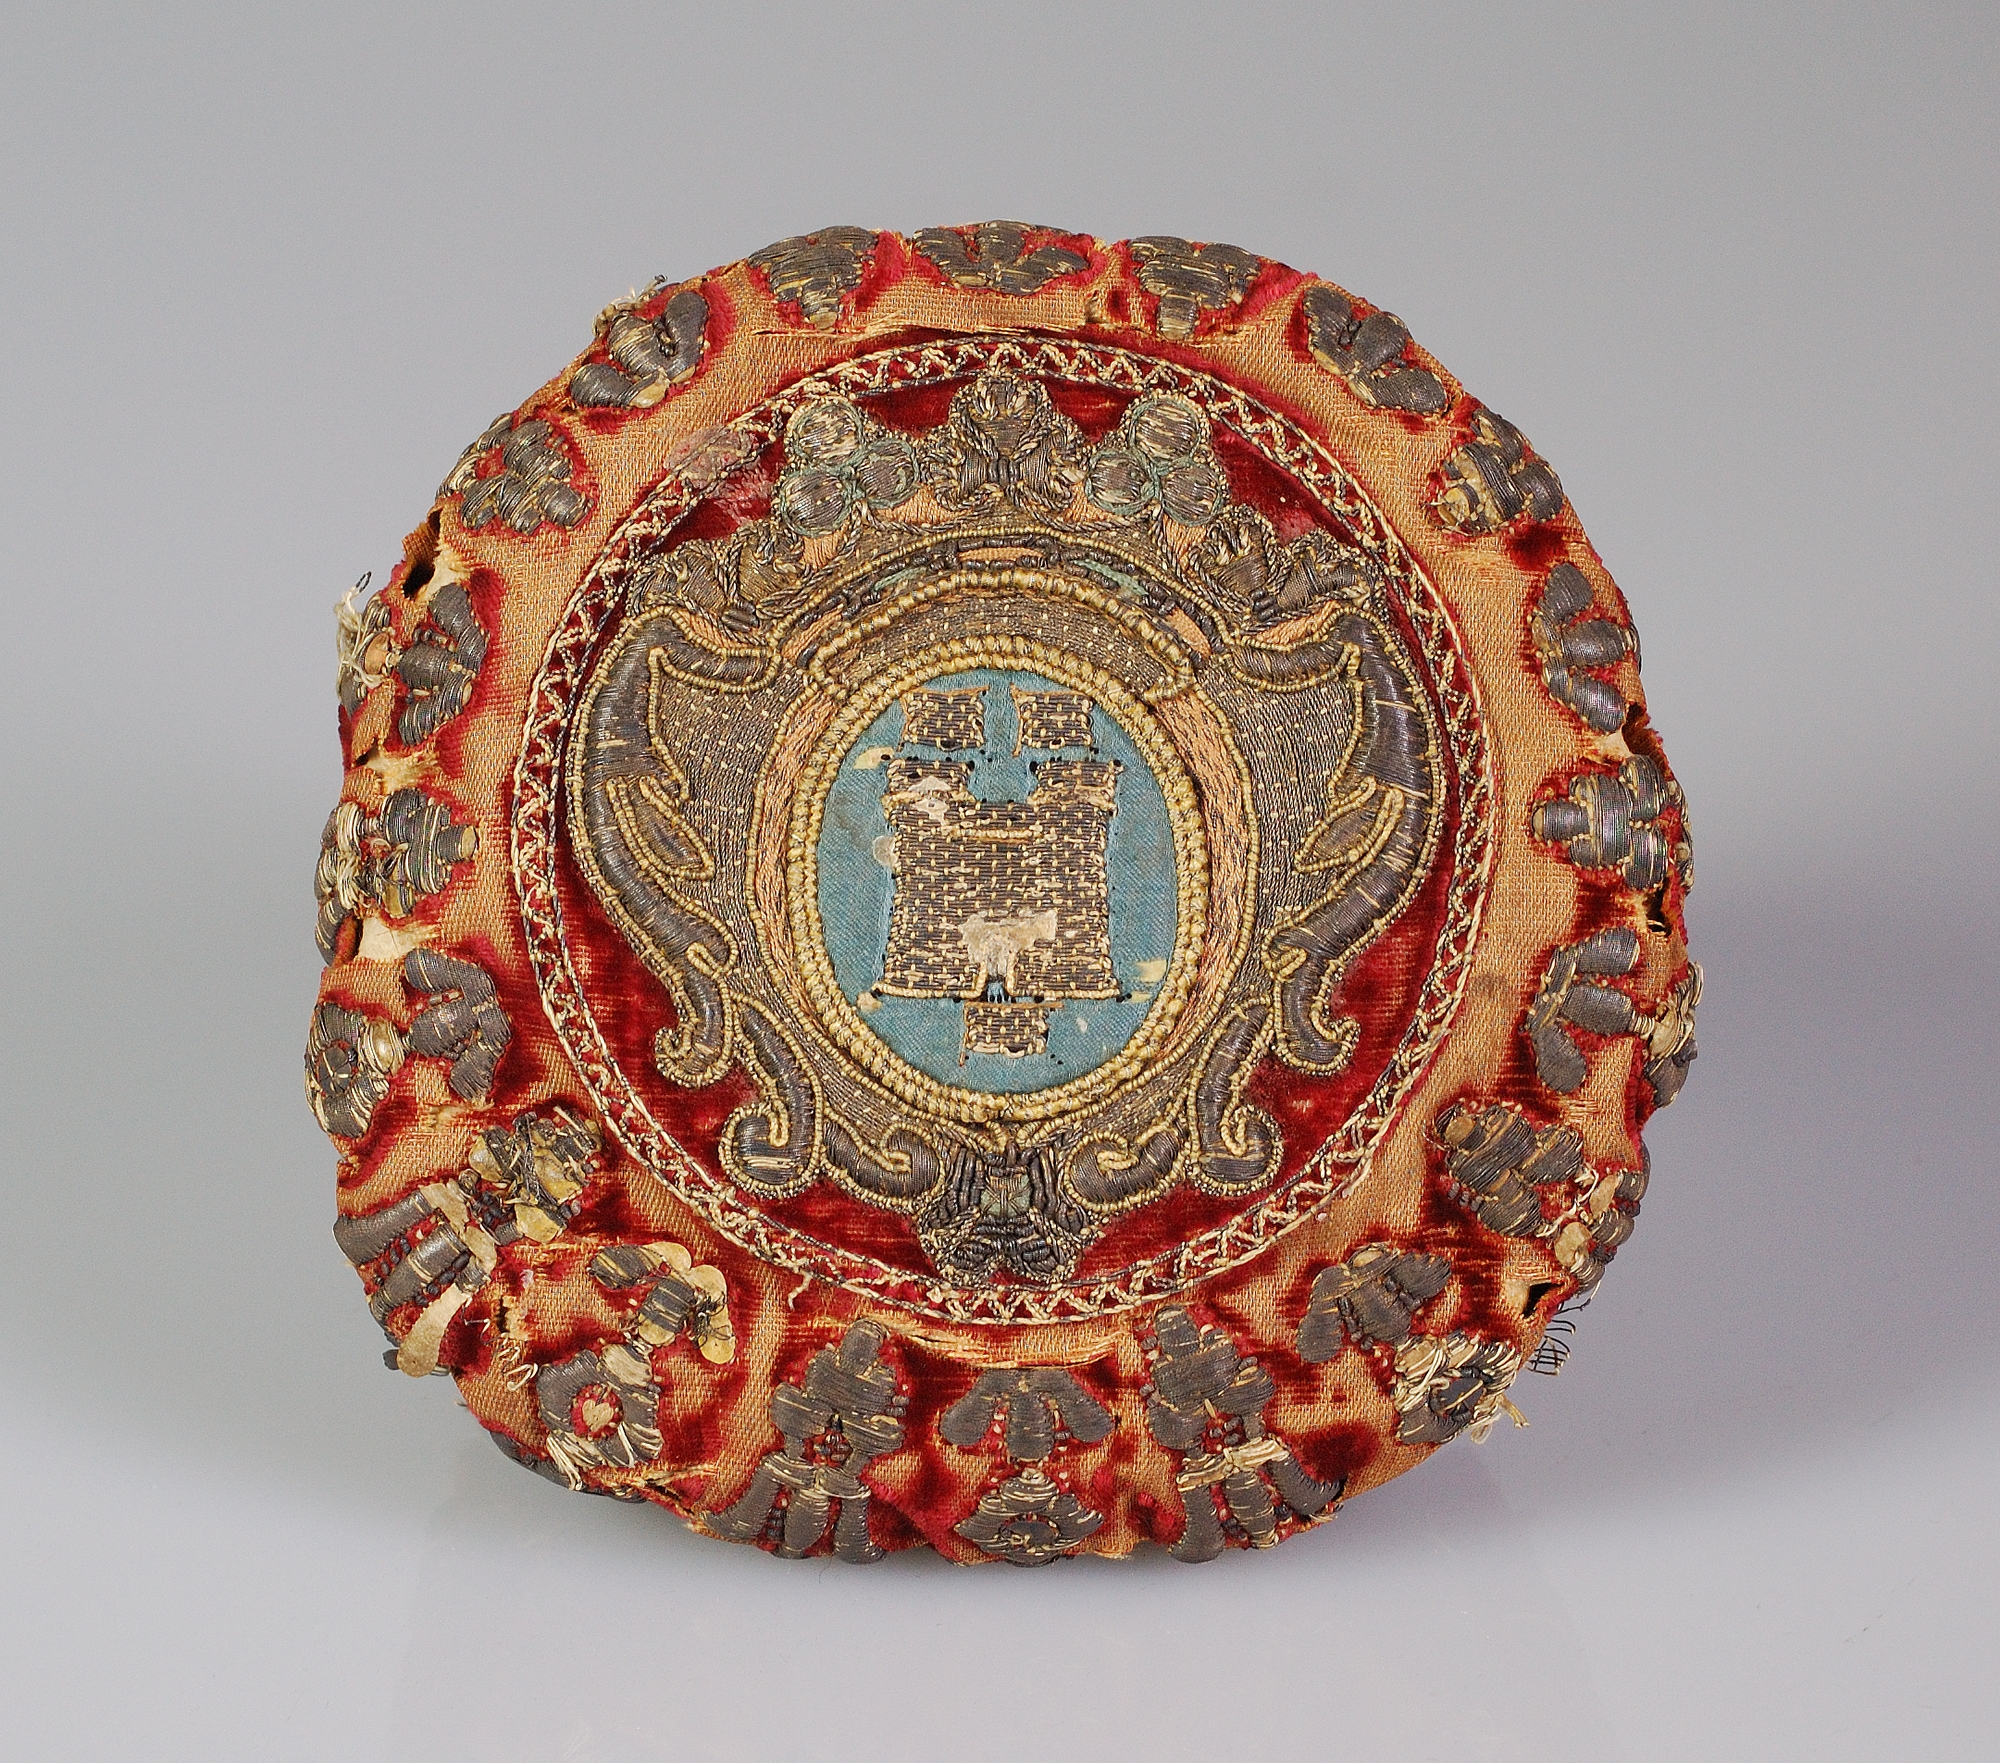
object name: gaming purse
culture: french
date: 1667-1700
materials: leather, silk